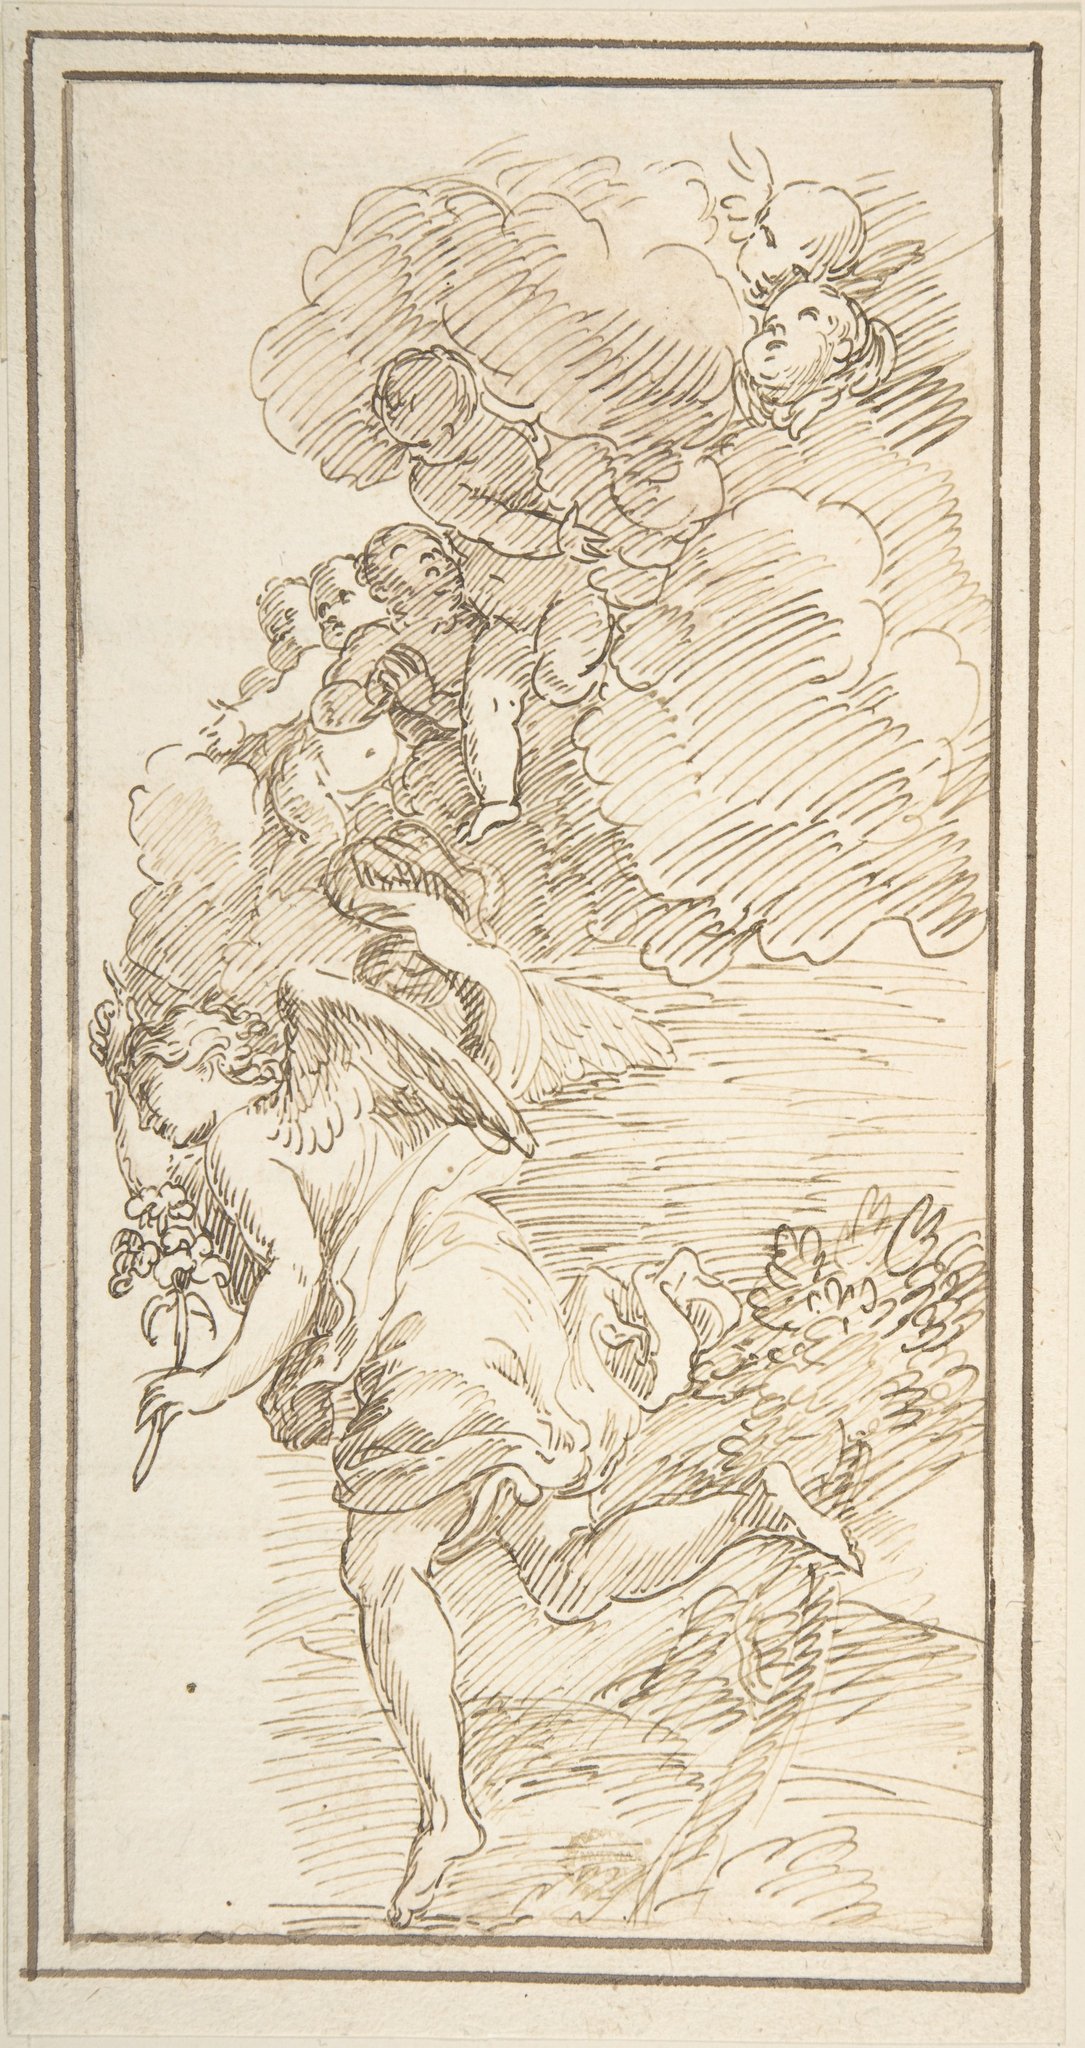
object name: drawing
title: Archangel Holding a Lily in a Landscape with Clouds Bearing Putti (Fragment of a Scene of the Annunciation)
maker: anonymous, italian, 18th century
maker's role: artist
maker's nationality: italian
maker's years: 1700-1800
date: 1701-1800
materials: ink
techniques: drawing, pen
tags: putti,angels